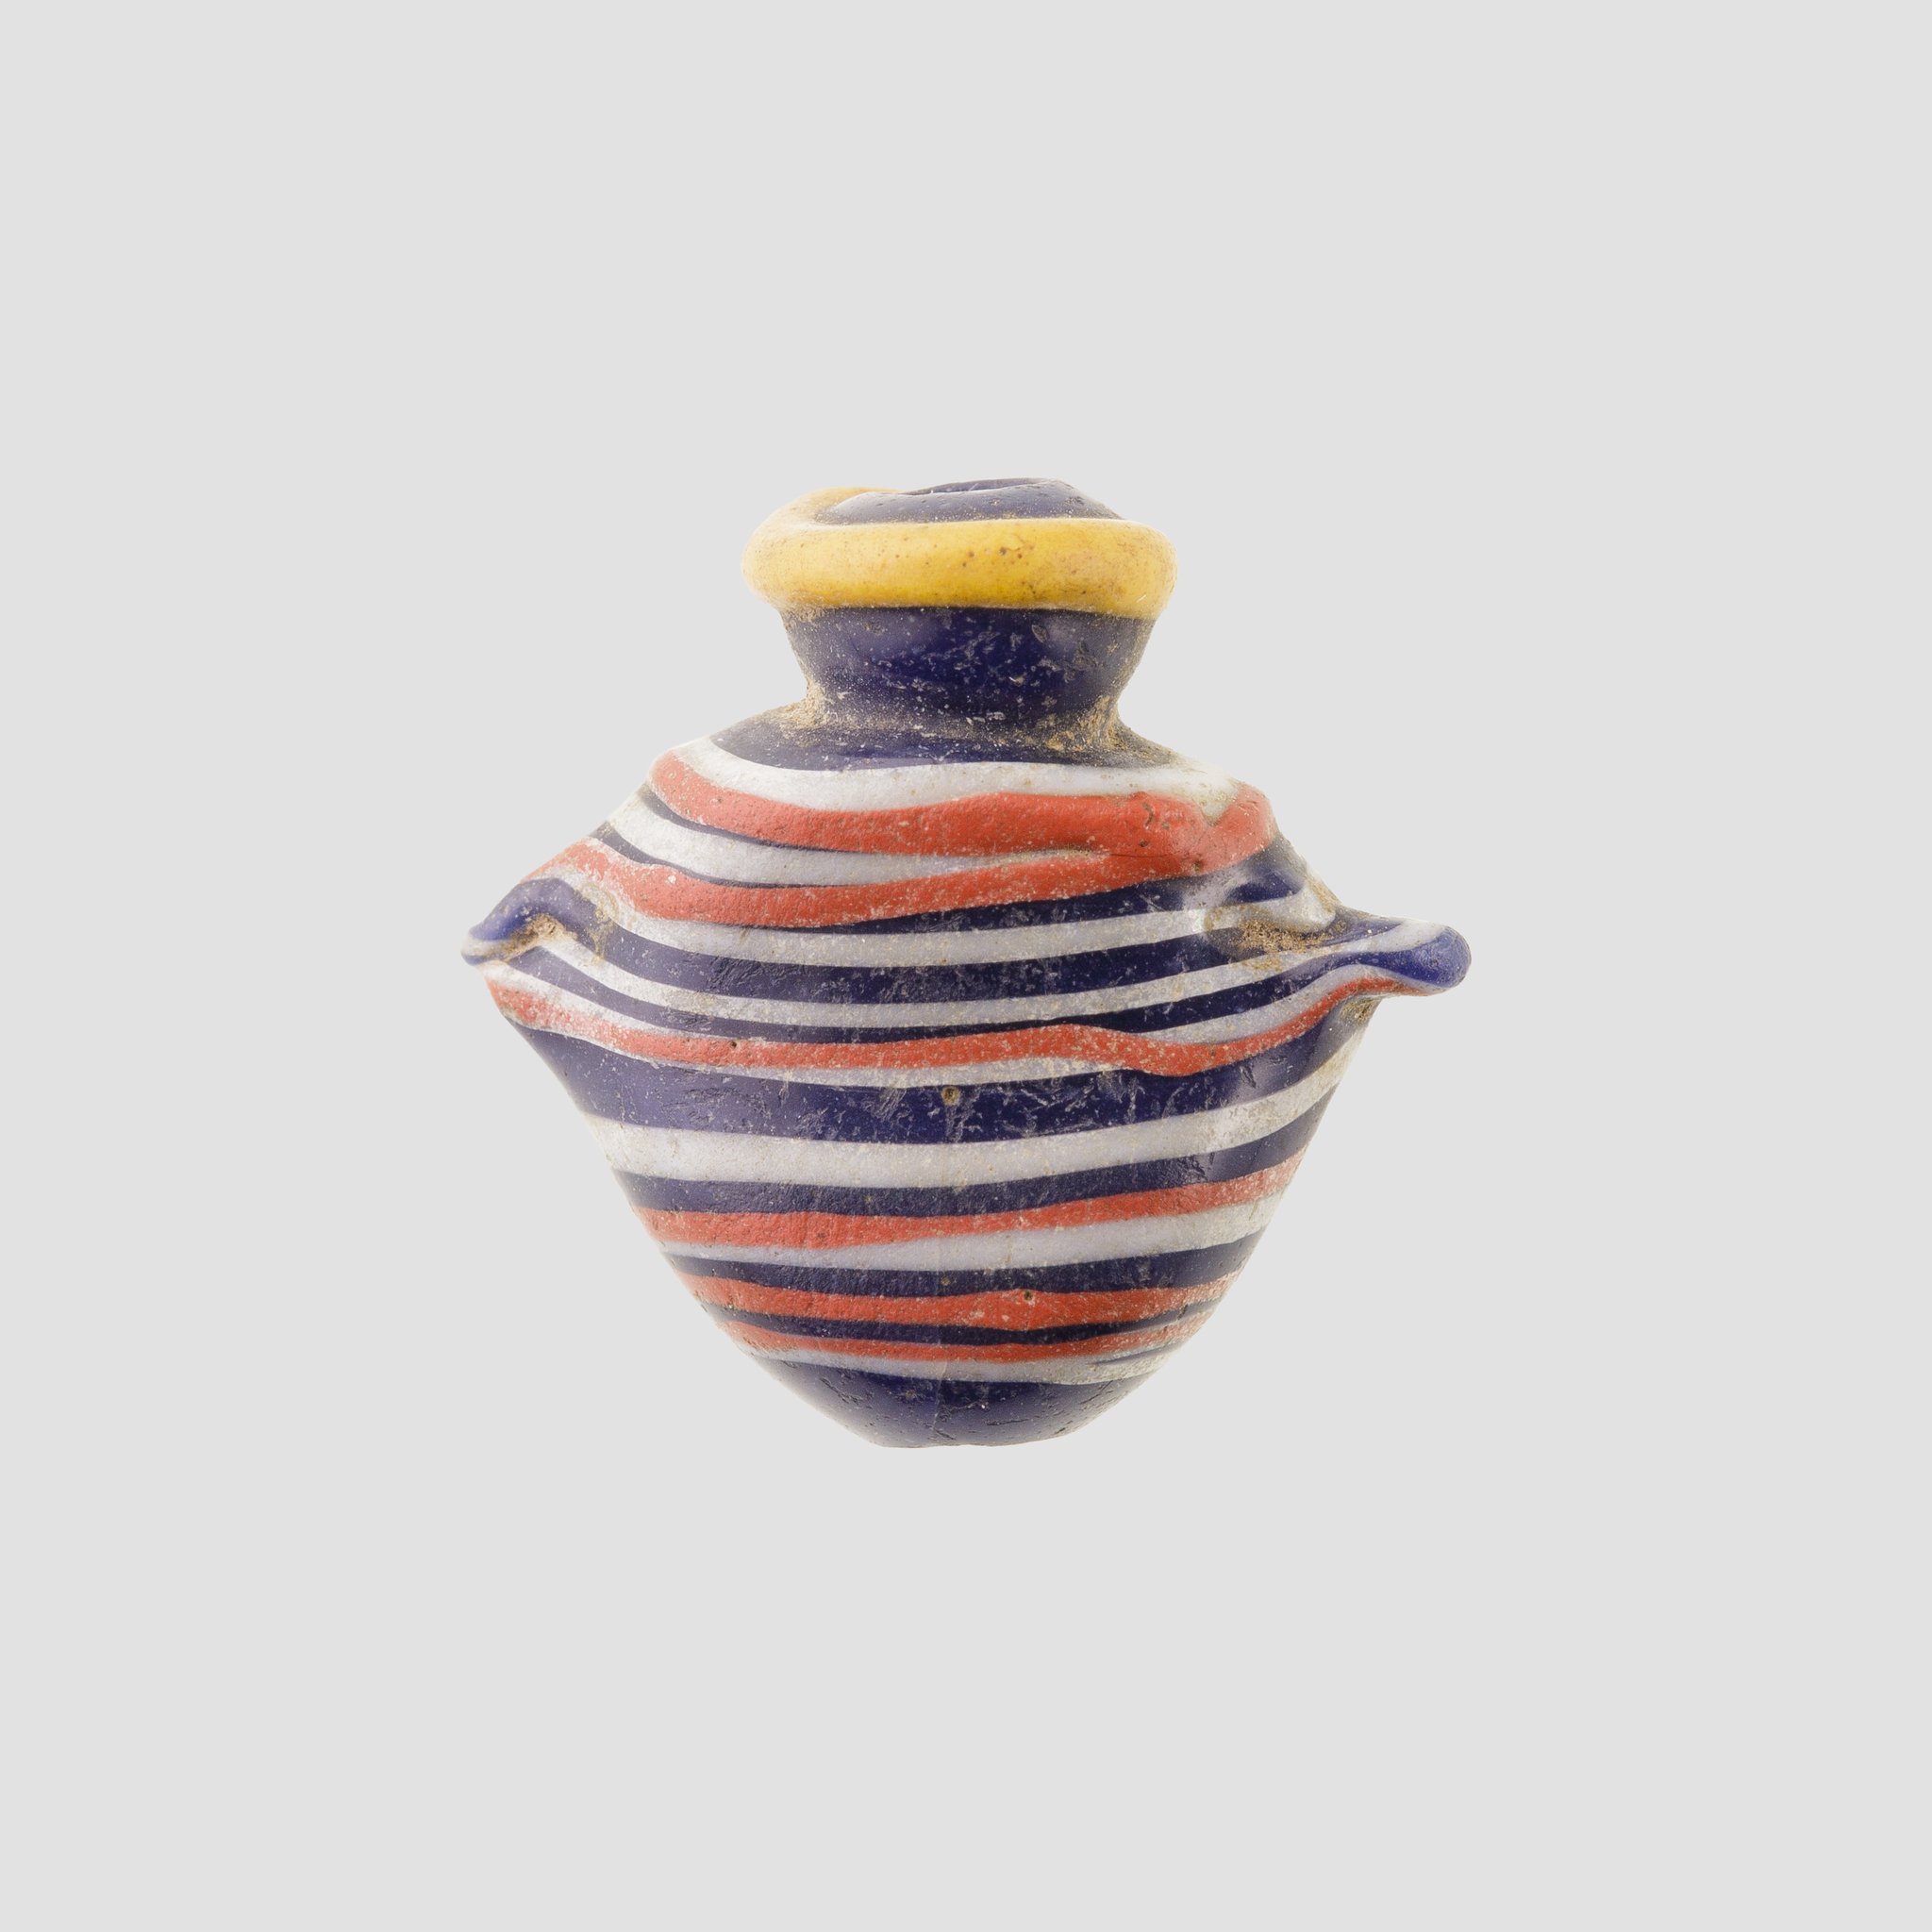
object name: amulet, heart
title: Amulet in the Shape of a Heart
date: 1400-1295 BCE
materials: glass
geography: egypt